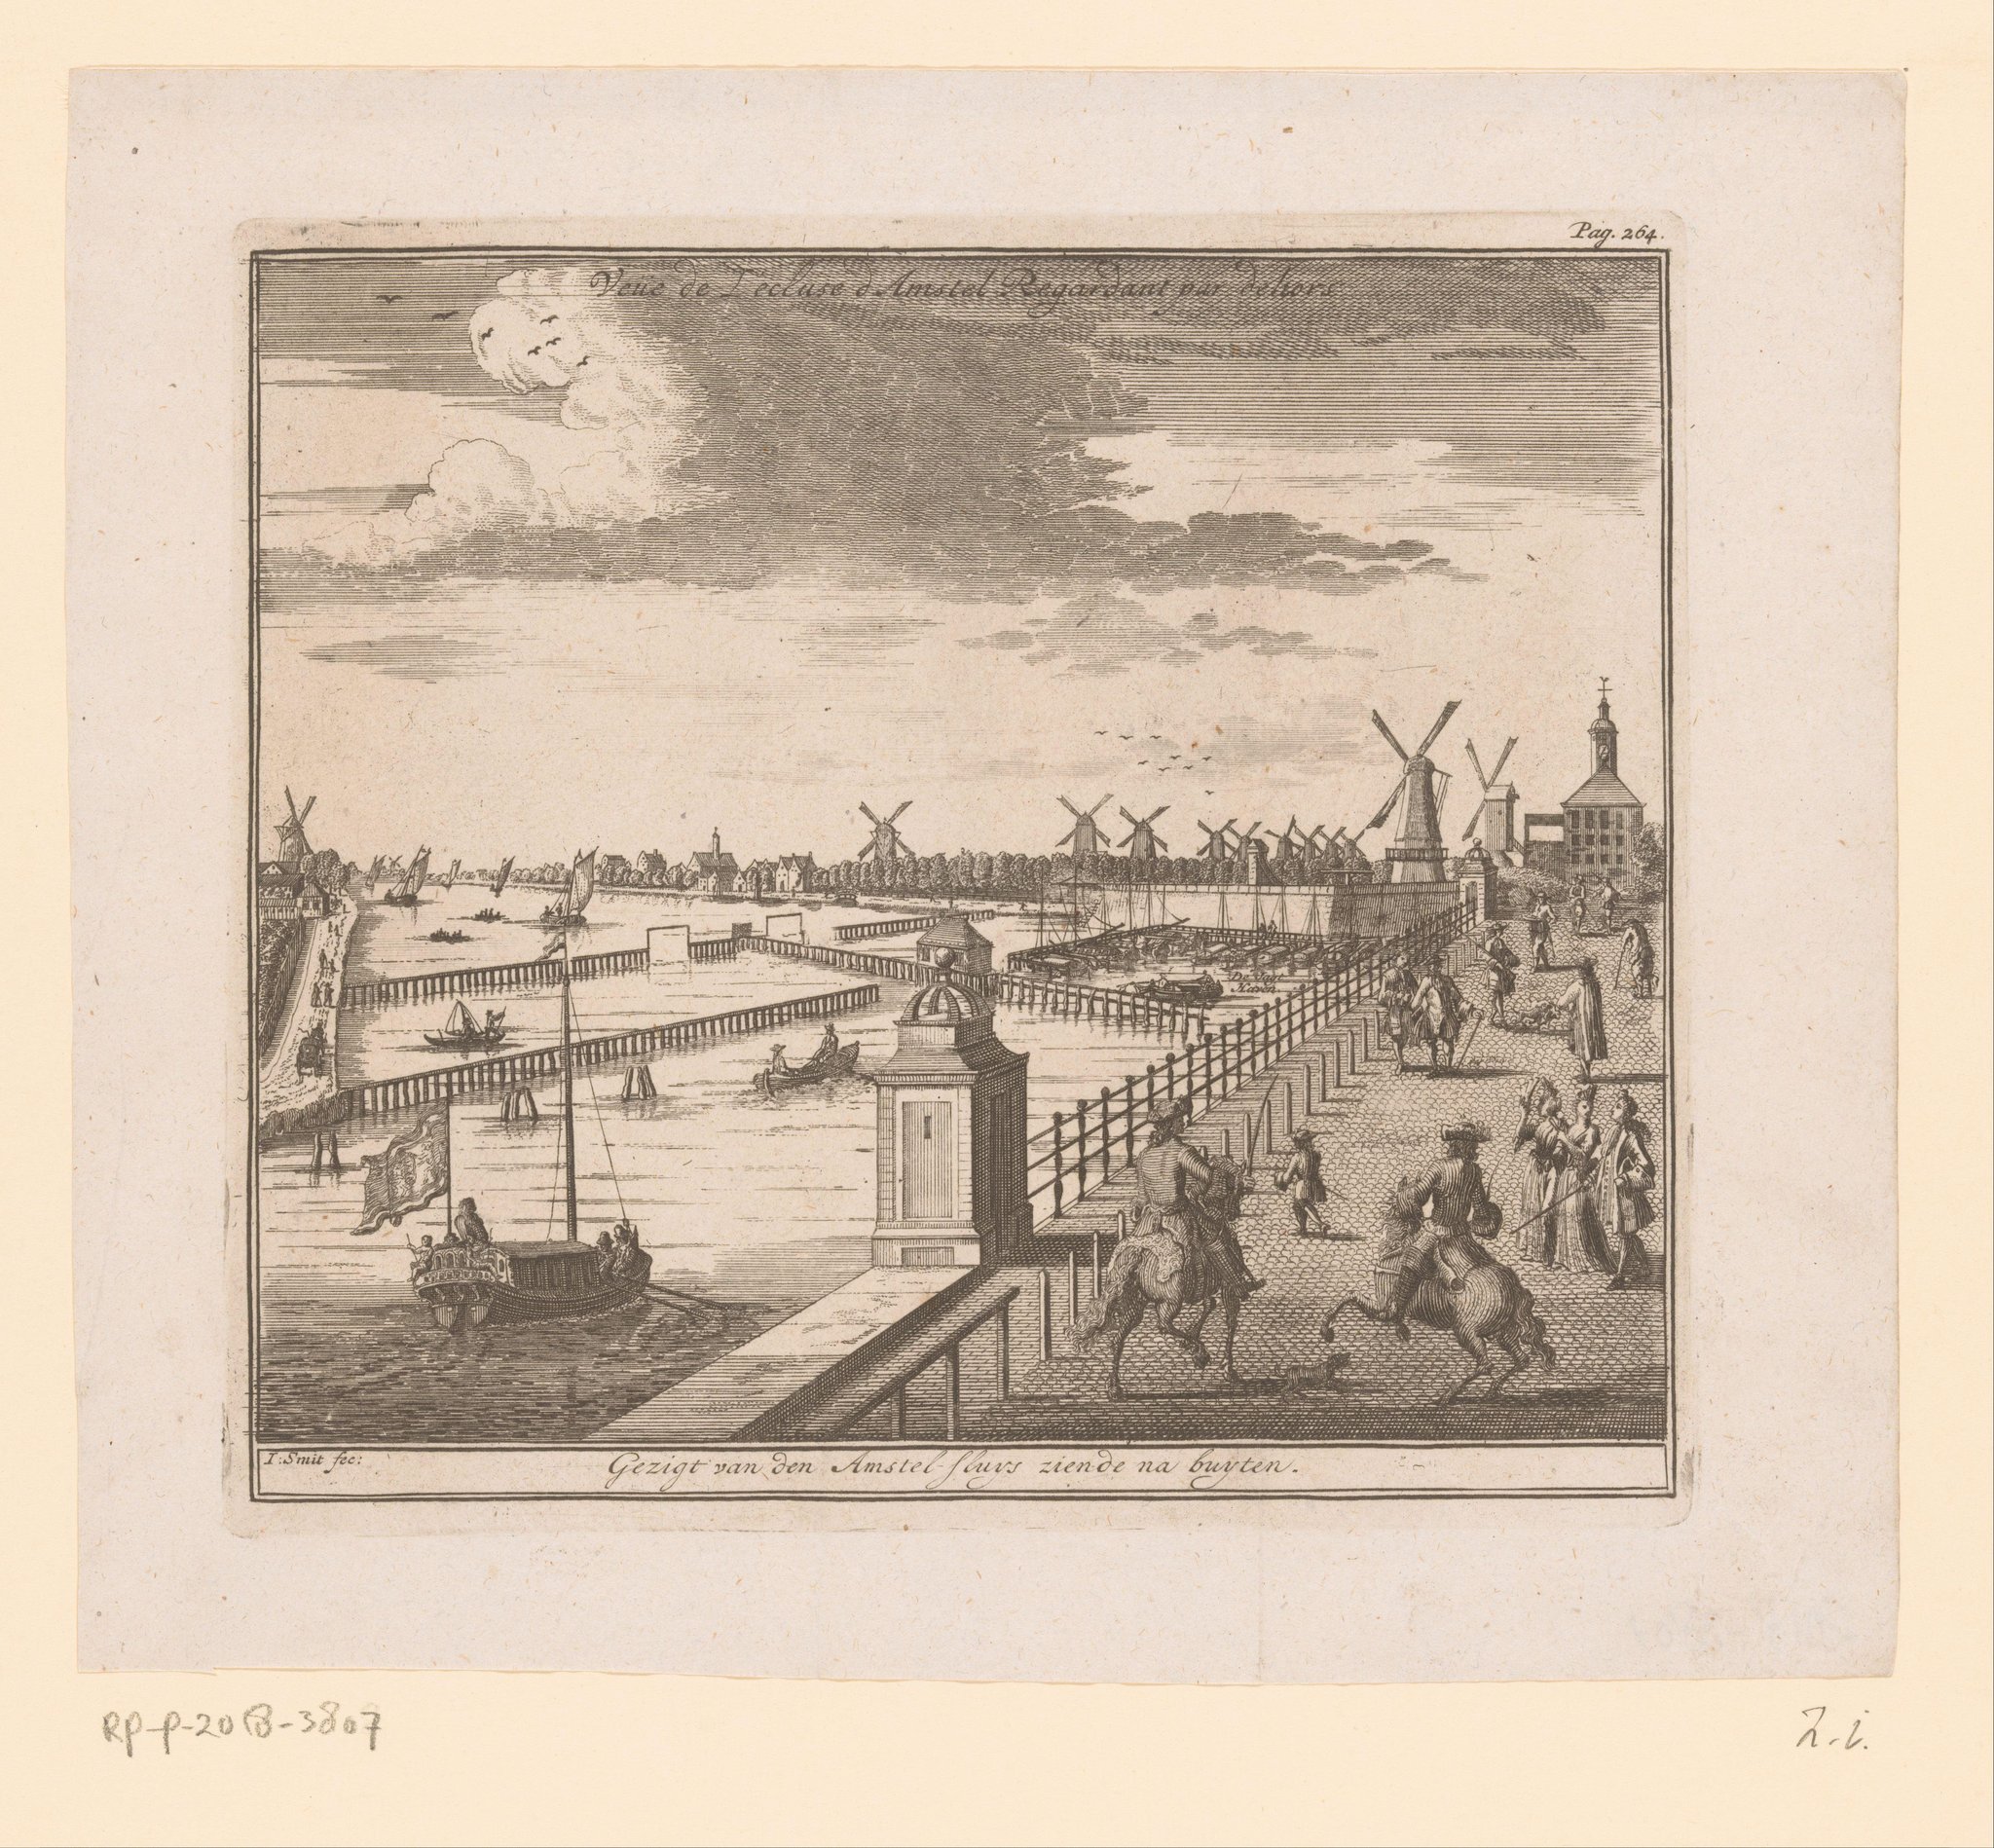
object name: print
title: Gezicht op de Hogesluis en de Amstel, met links de Weesperzijde en rechts de Utrechtsepoort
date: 1685-1748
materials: paper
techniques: etching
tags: canals, waters (in city), bridge in city across river, canal, etc., windmill